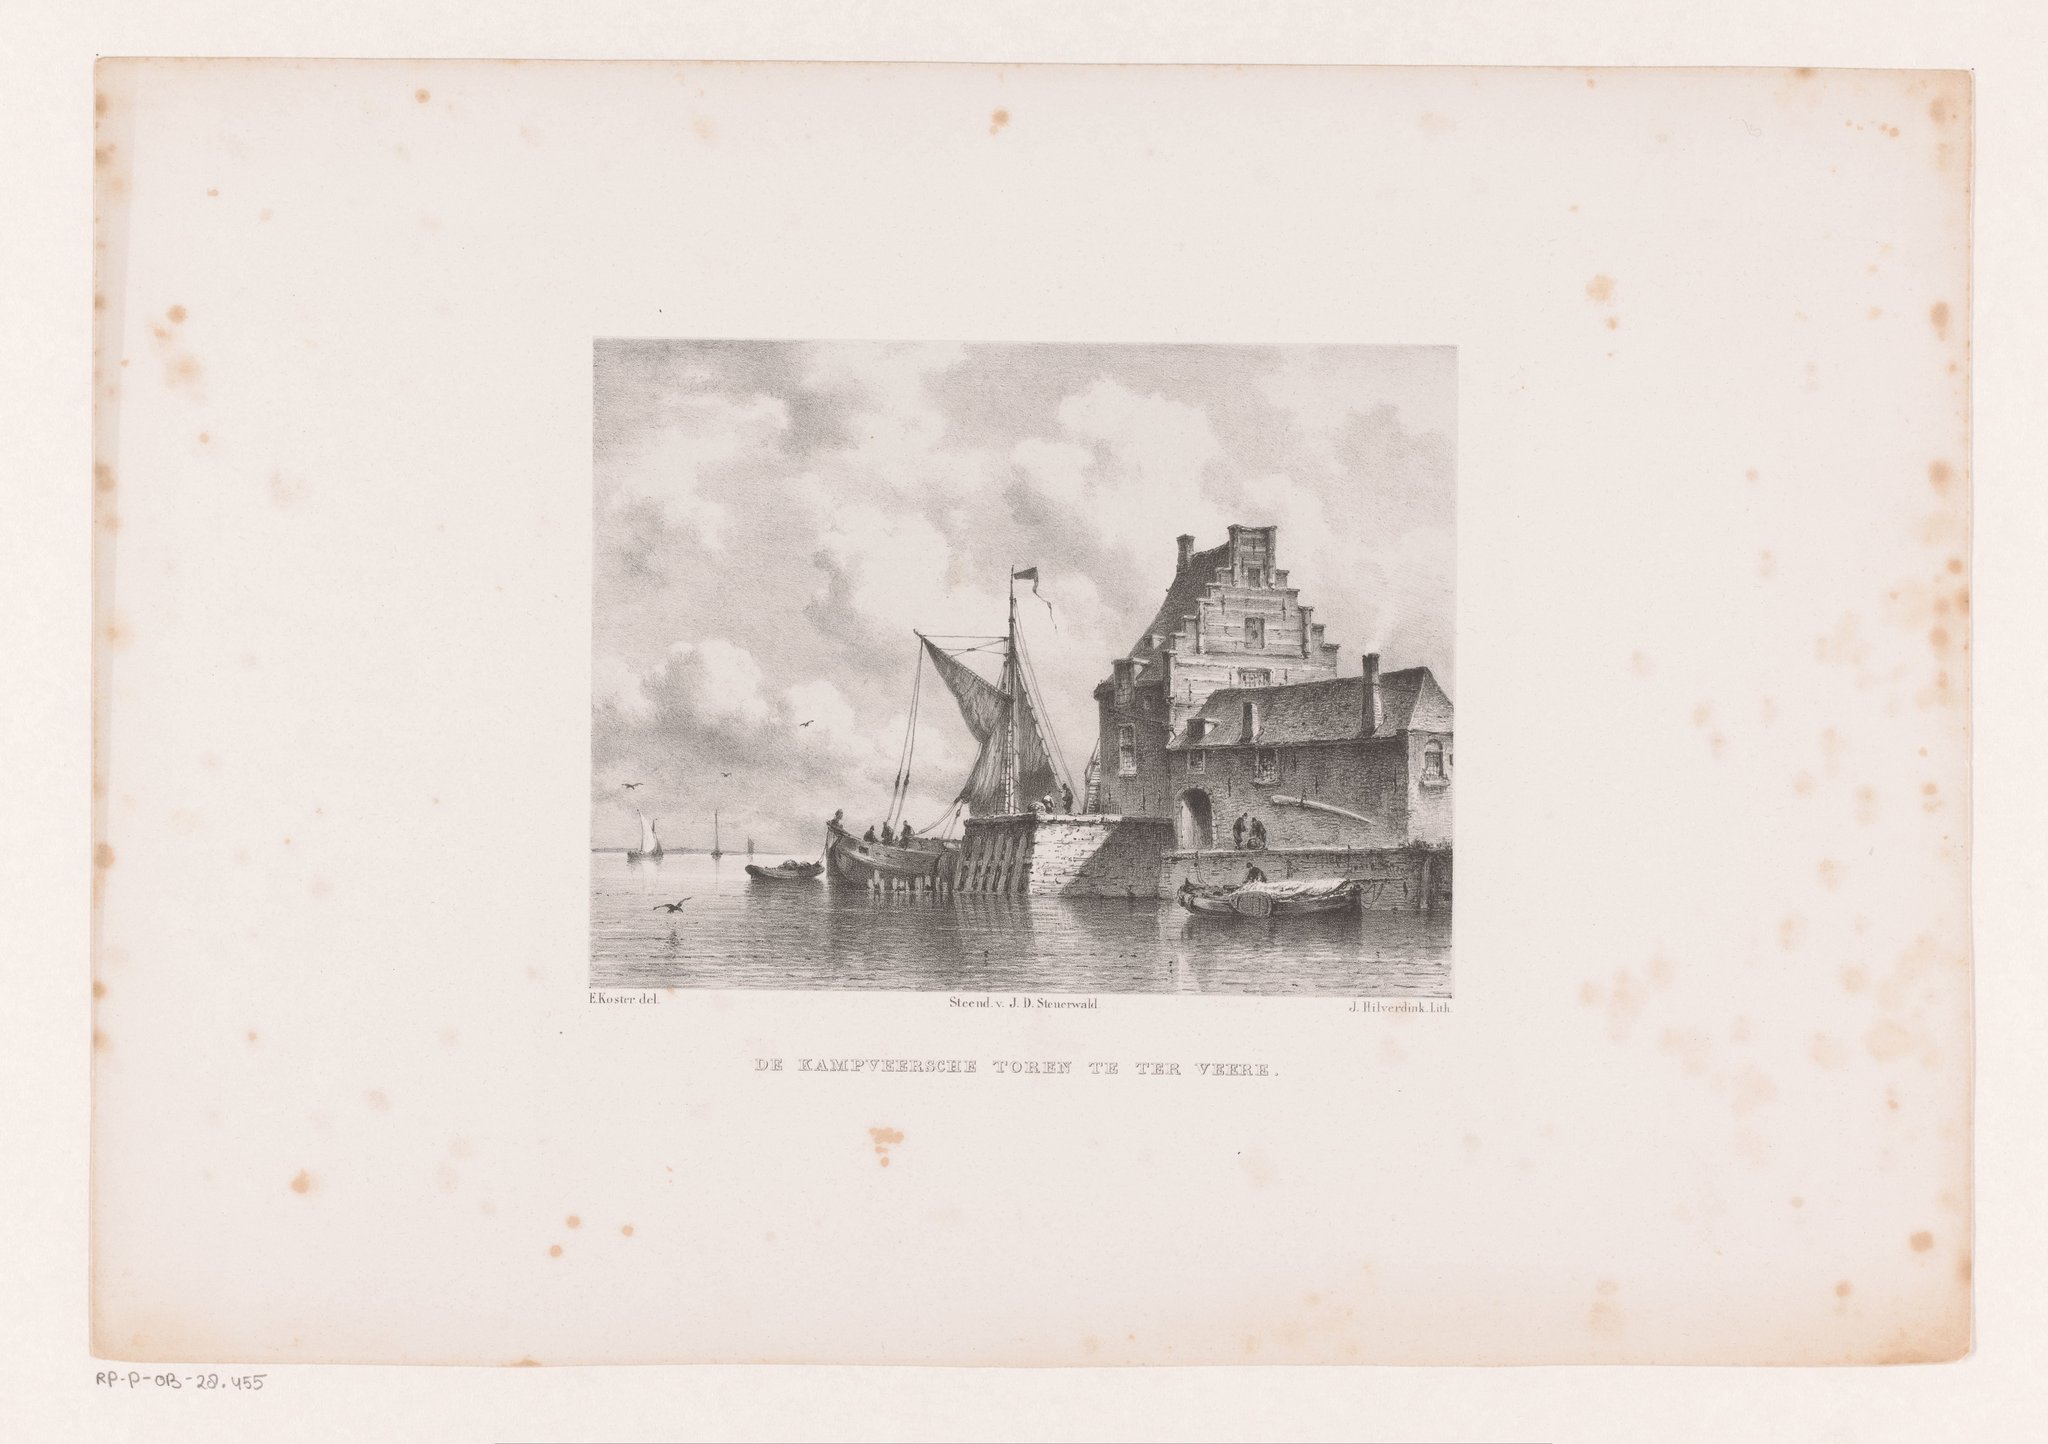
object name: print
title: De Kampveersche toren te Ter Veere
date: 1858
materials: paper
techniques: lithograph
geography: amsterdam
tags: sailing-ship, sailing-boat, towers ~ fortified city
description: Deze prent komt uit: Koster, E. 'E. Koster's schetsboek: Nederlandsche Stads- en Havengezichten, uitgegeven onder medewerking van de maatschappij Arti et Amicitiae, Amsterdam, F. Buffa en Zn., e.a.' Amsterdam 1858.